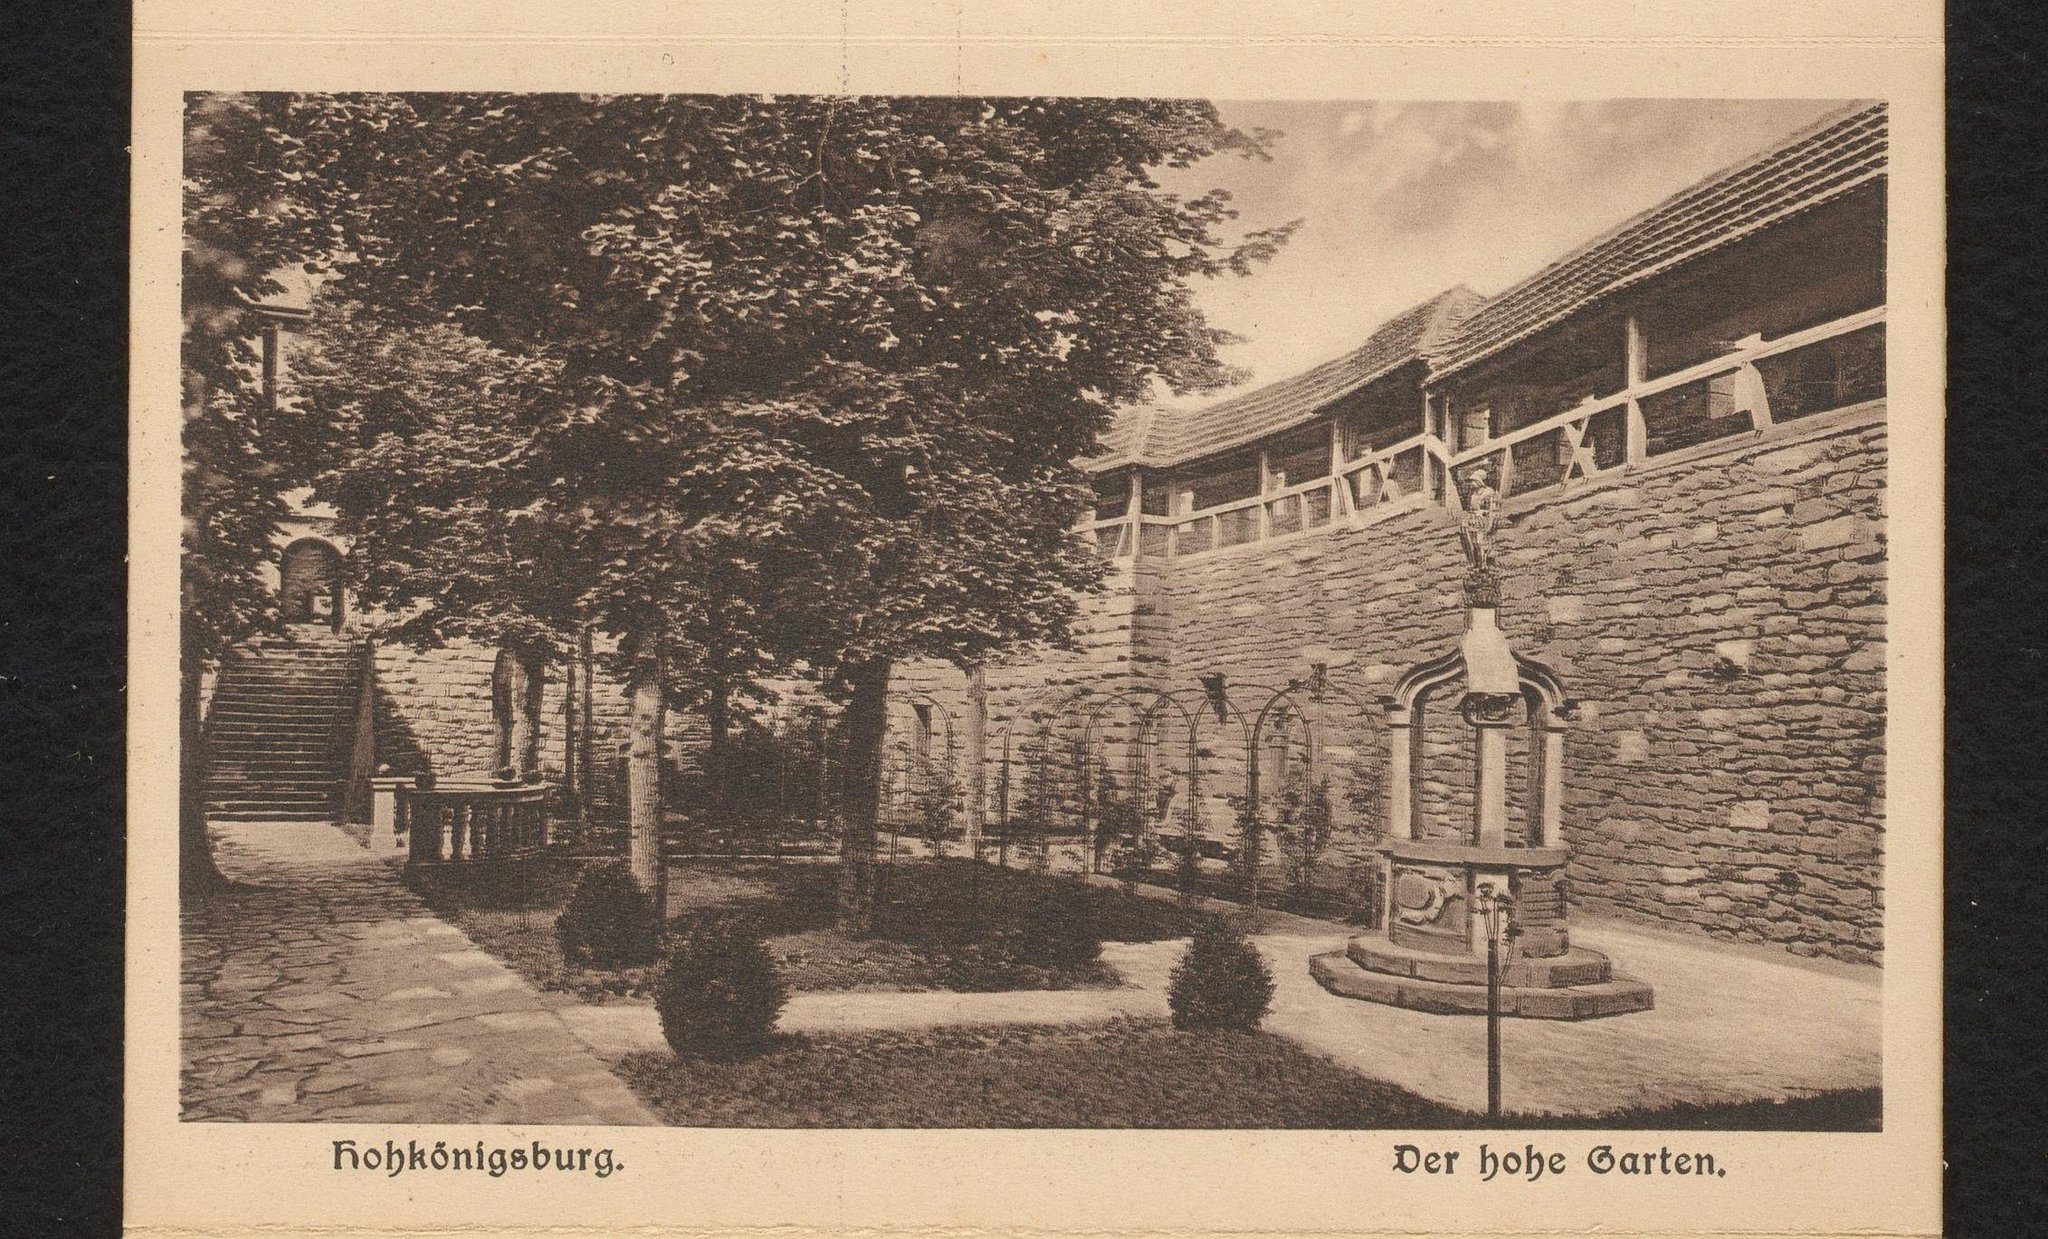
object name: photomechanical print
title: Hohkönigsburg. Der hohe Garten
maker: Anonymous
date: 1908-1913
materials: cardboard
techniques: photograph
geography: alsace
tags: castle, garden